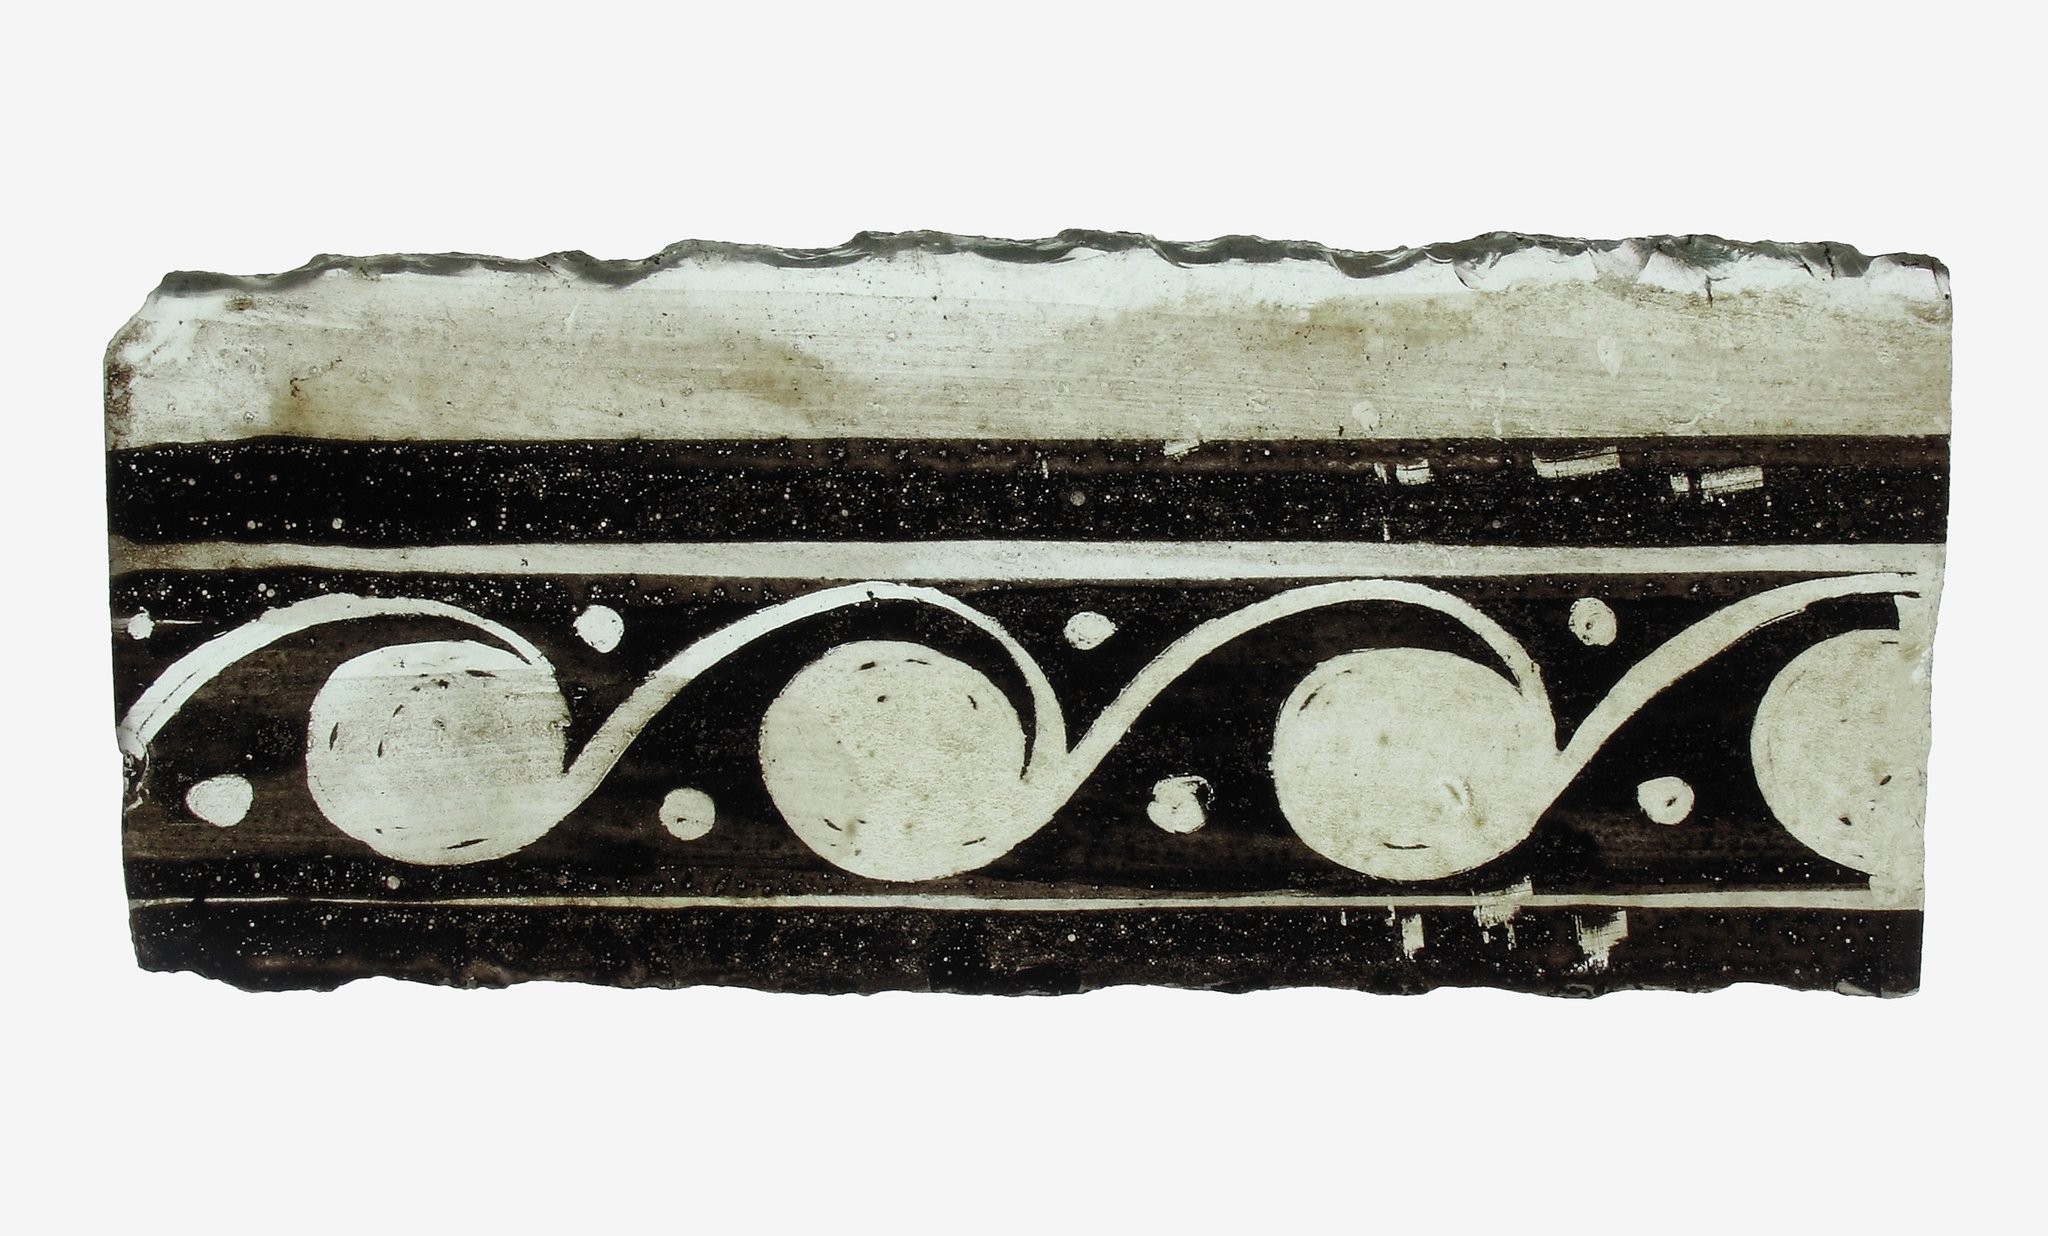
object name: fragment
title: Glass Fragment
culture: european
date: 1301-1500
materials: glass